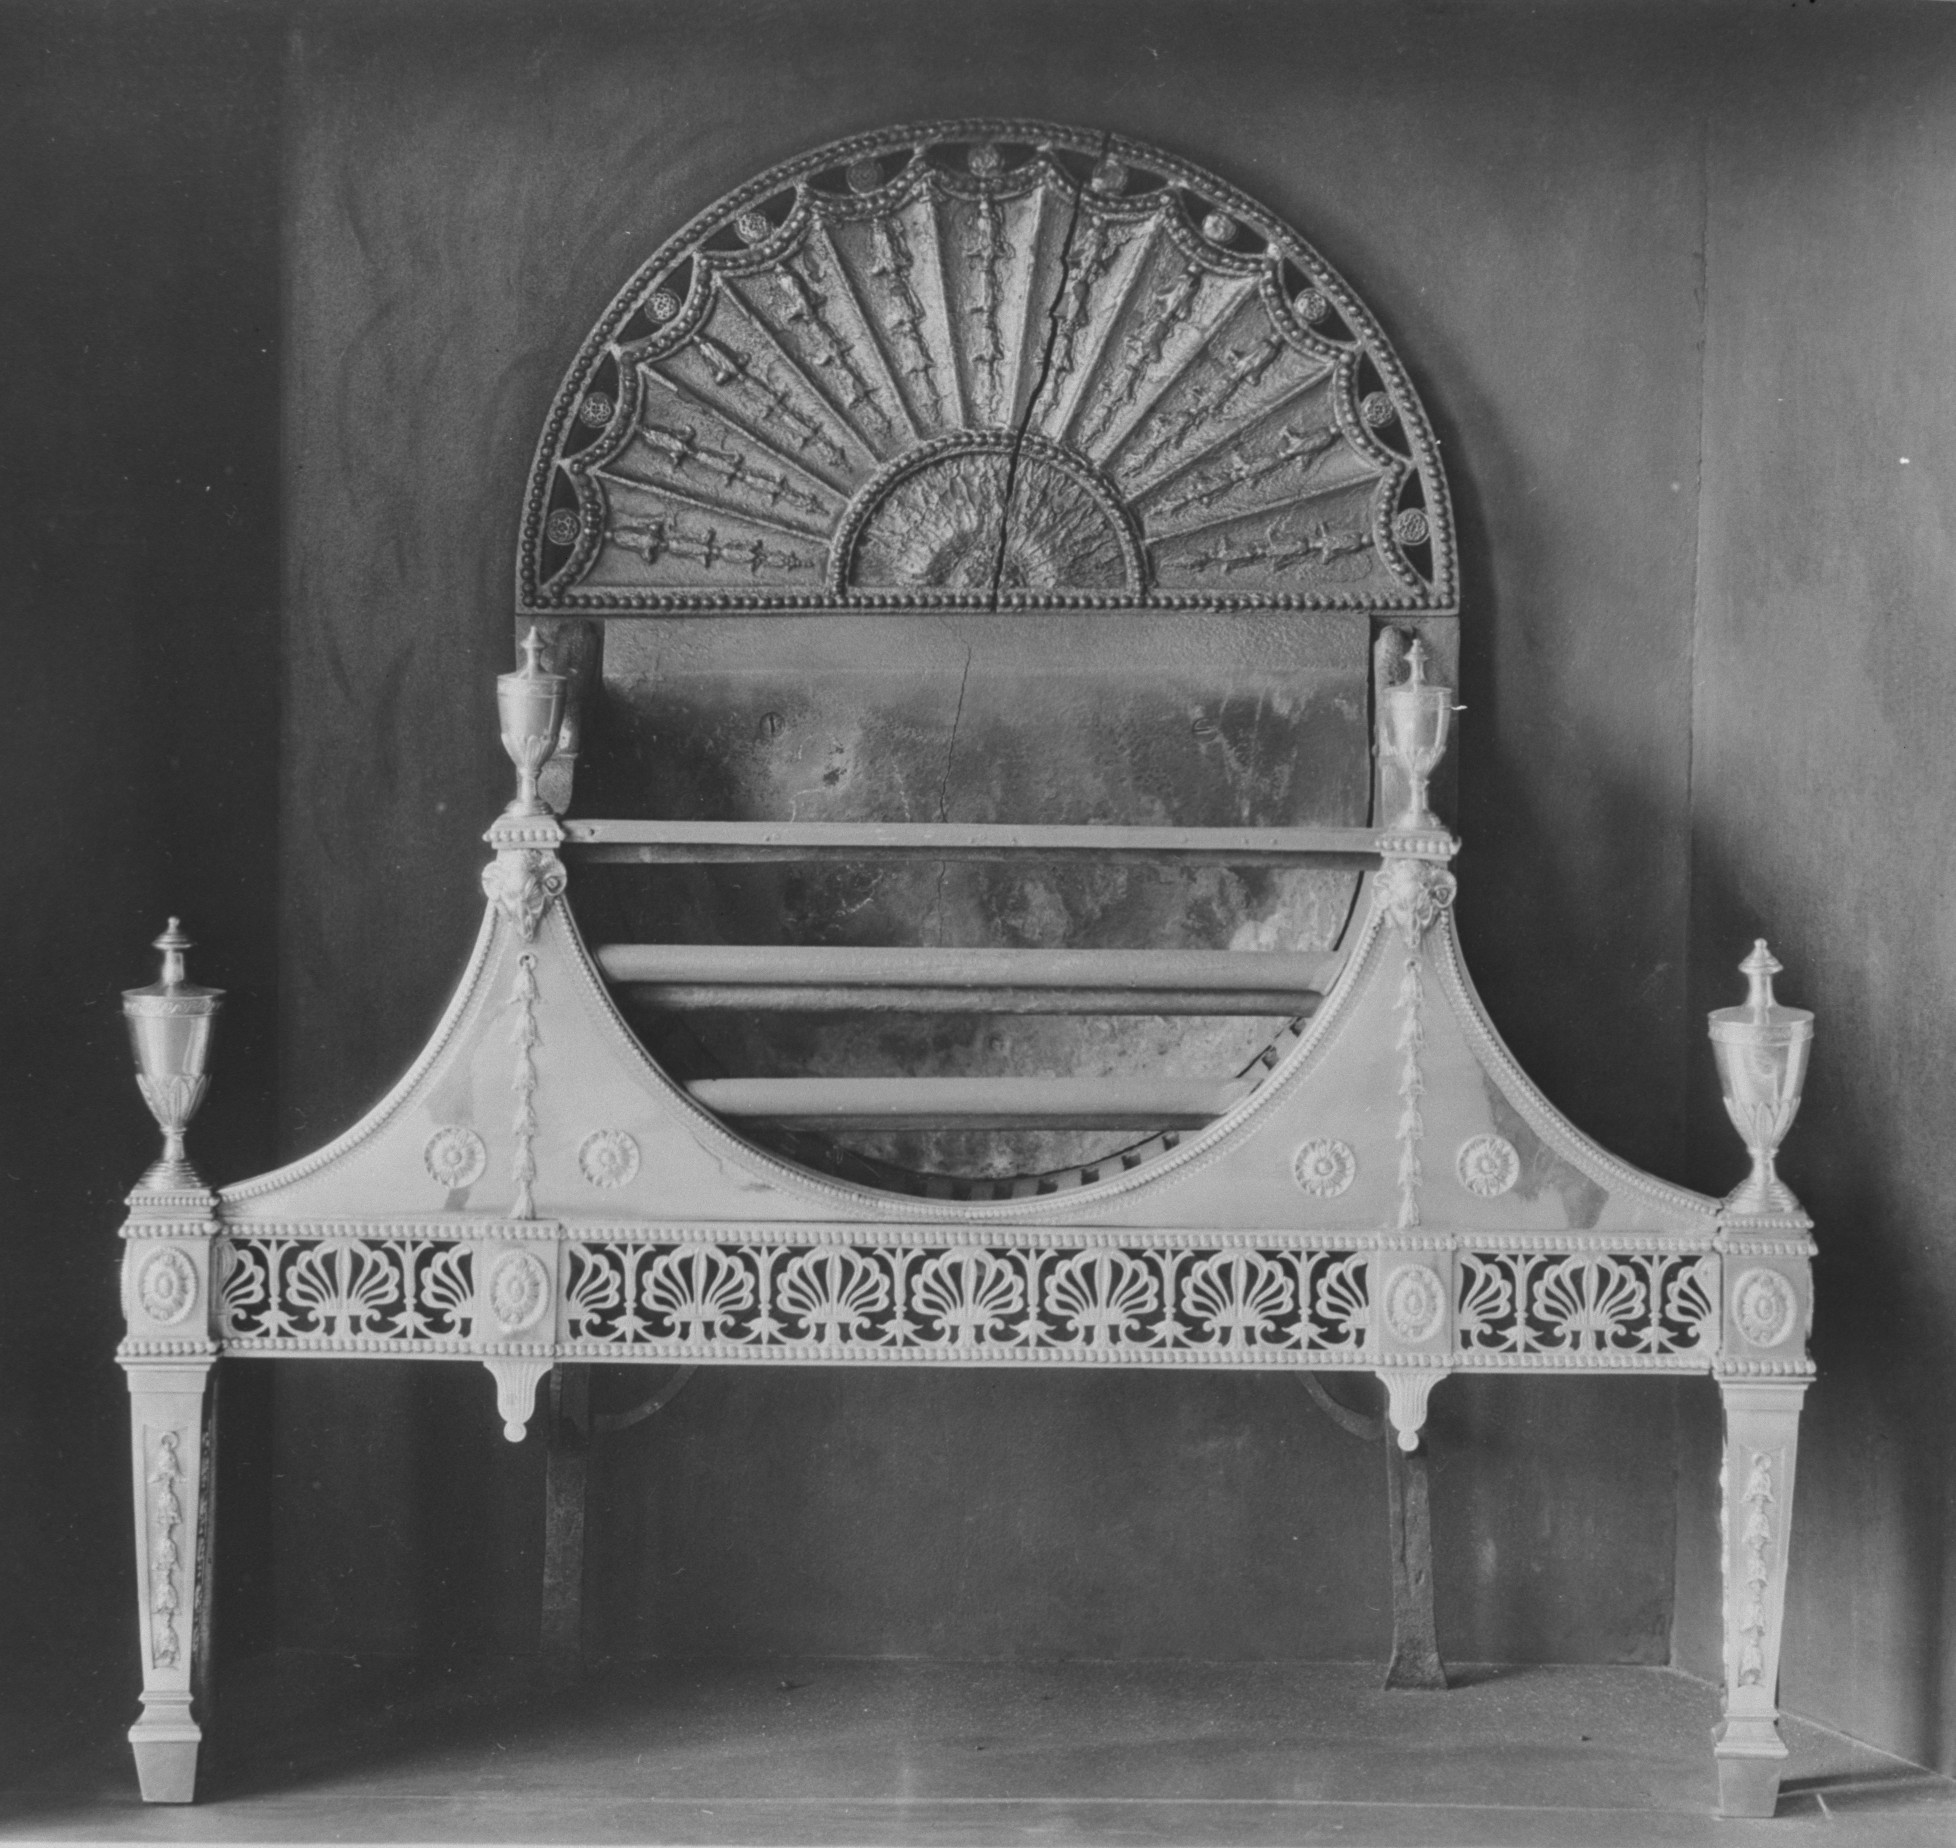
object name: basket grate and fireback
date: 1780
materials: iron